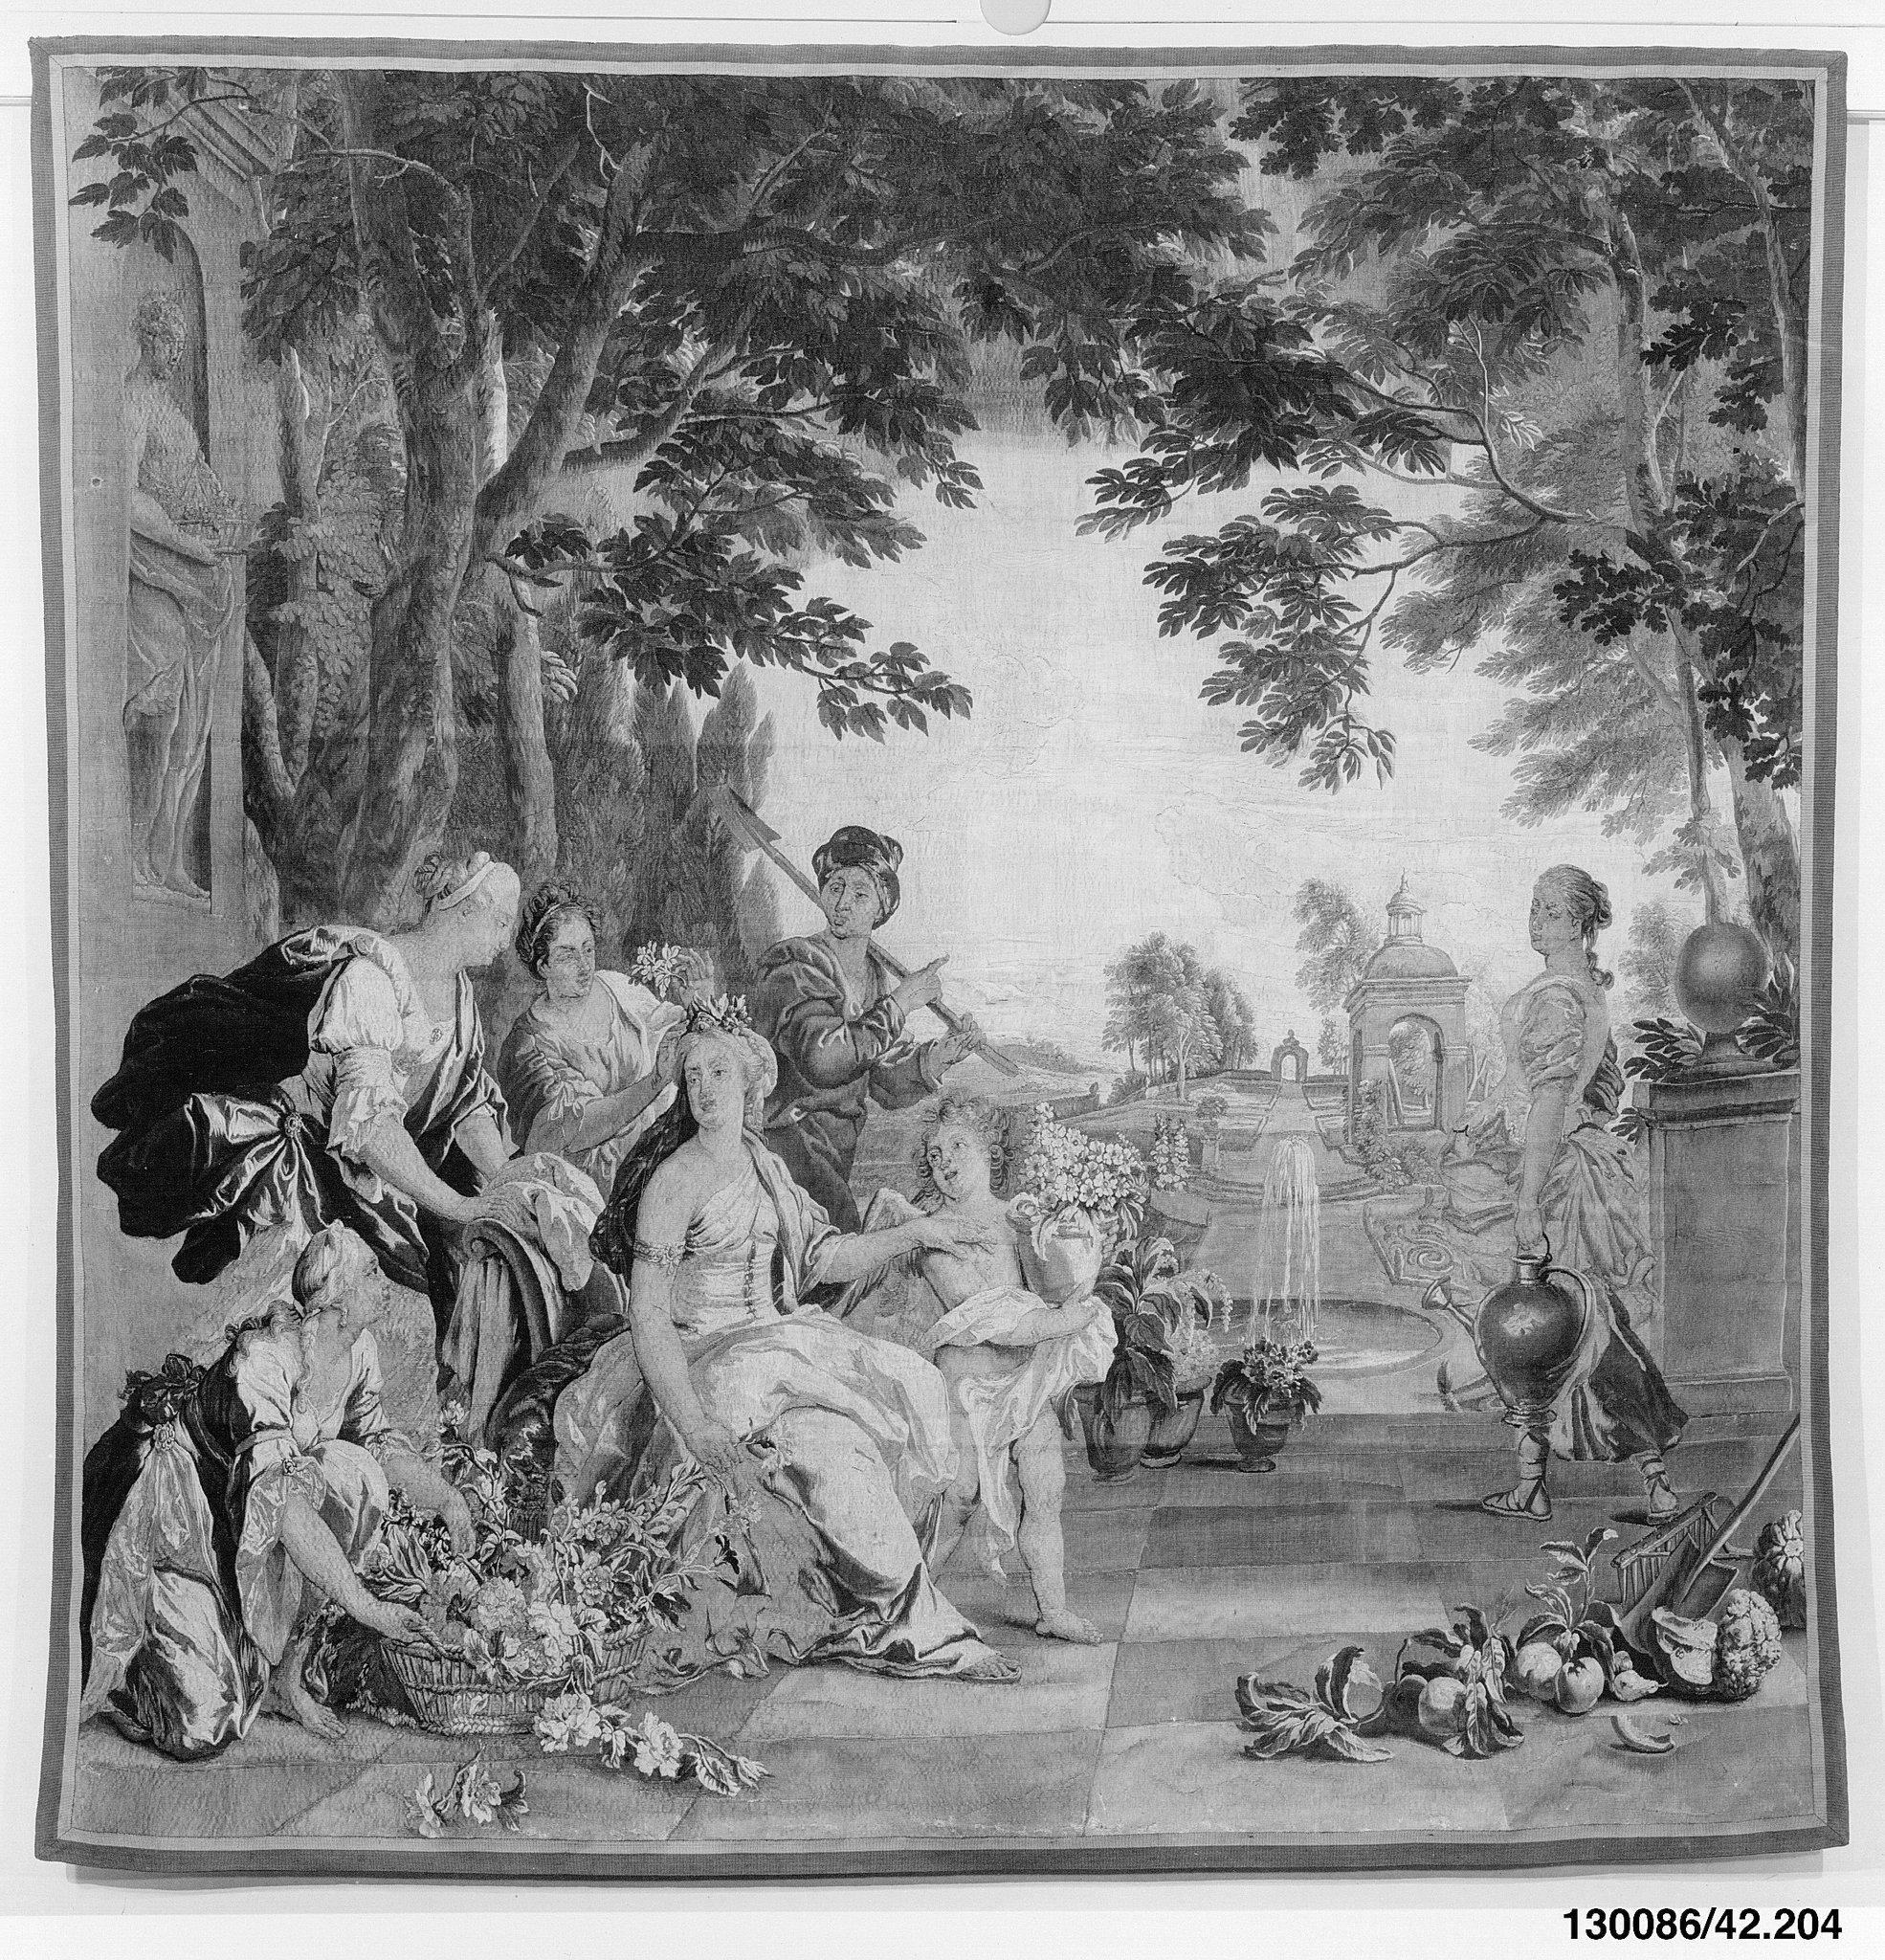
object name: tapestry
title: Flora from a set of the Triumph of the Gods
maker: jan van orley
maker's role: designer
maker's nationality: flemish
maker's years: 1665-1735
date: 1701-1750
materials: silk, wool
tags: fruit,flowers,trees